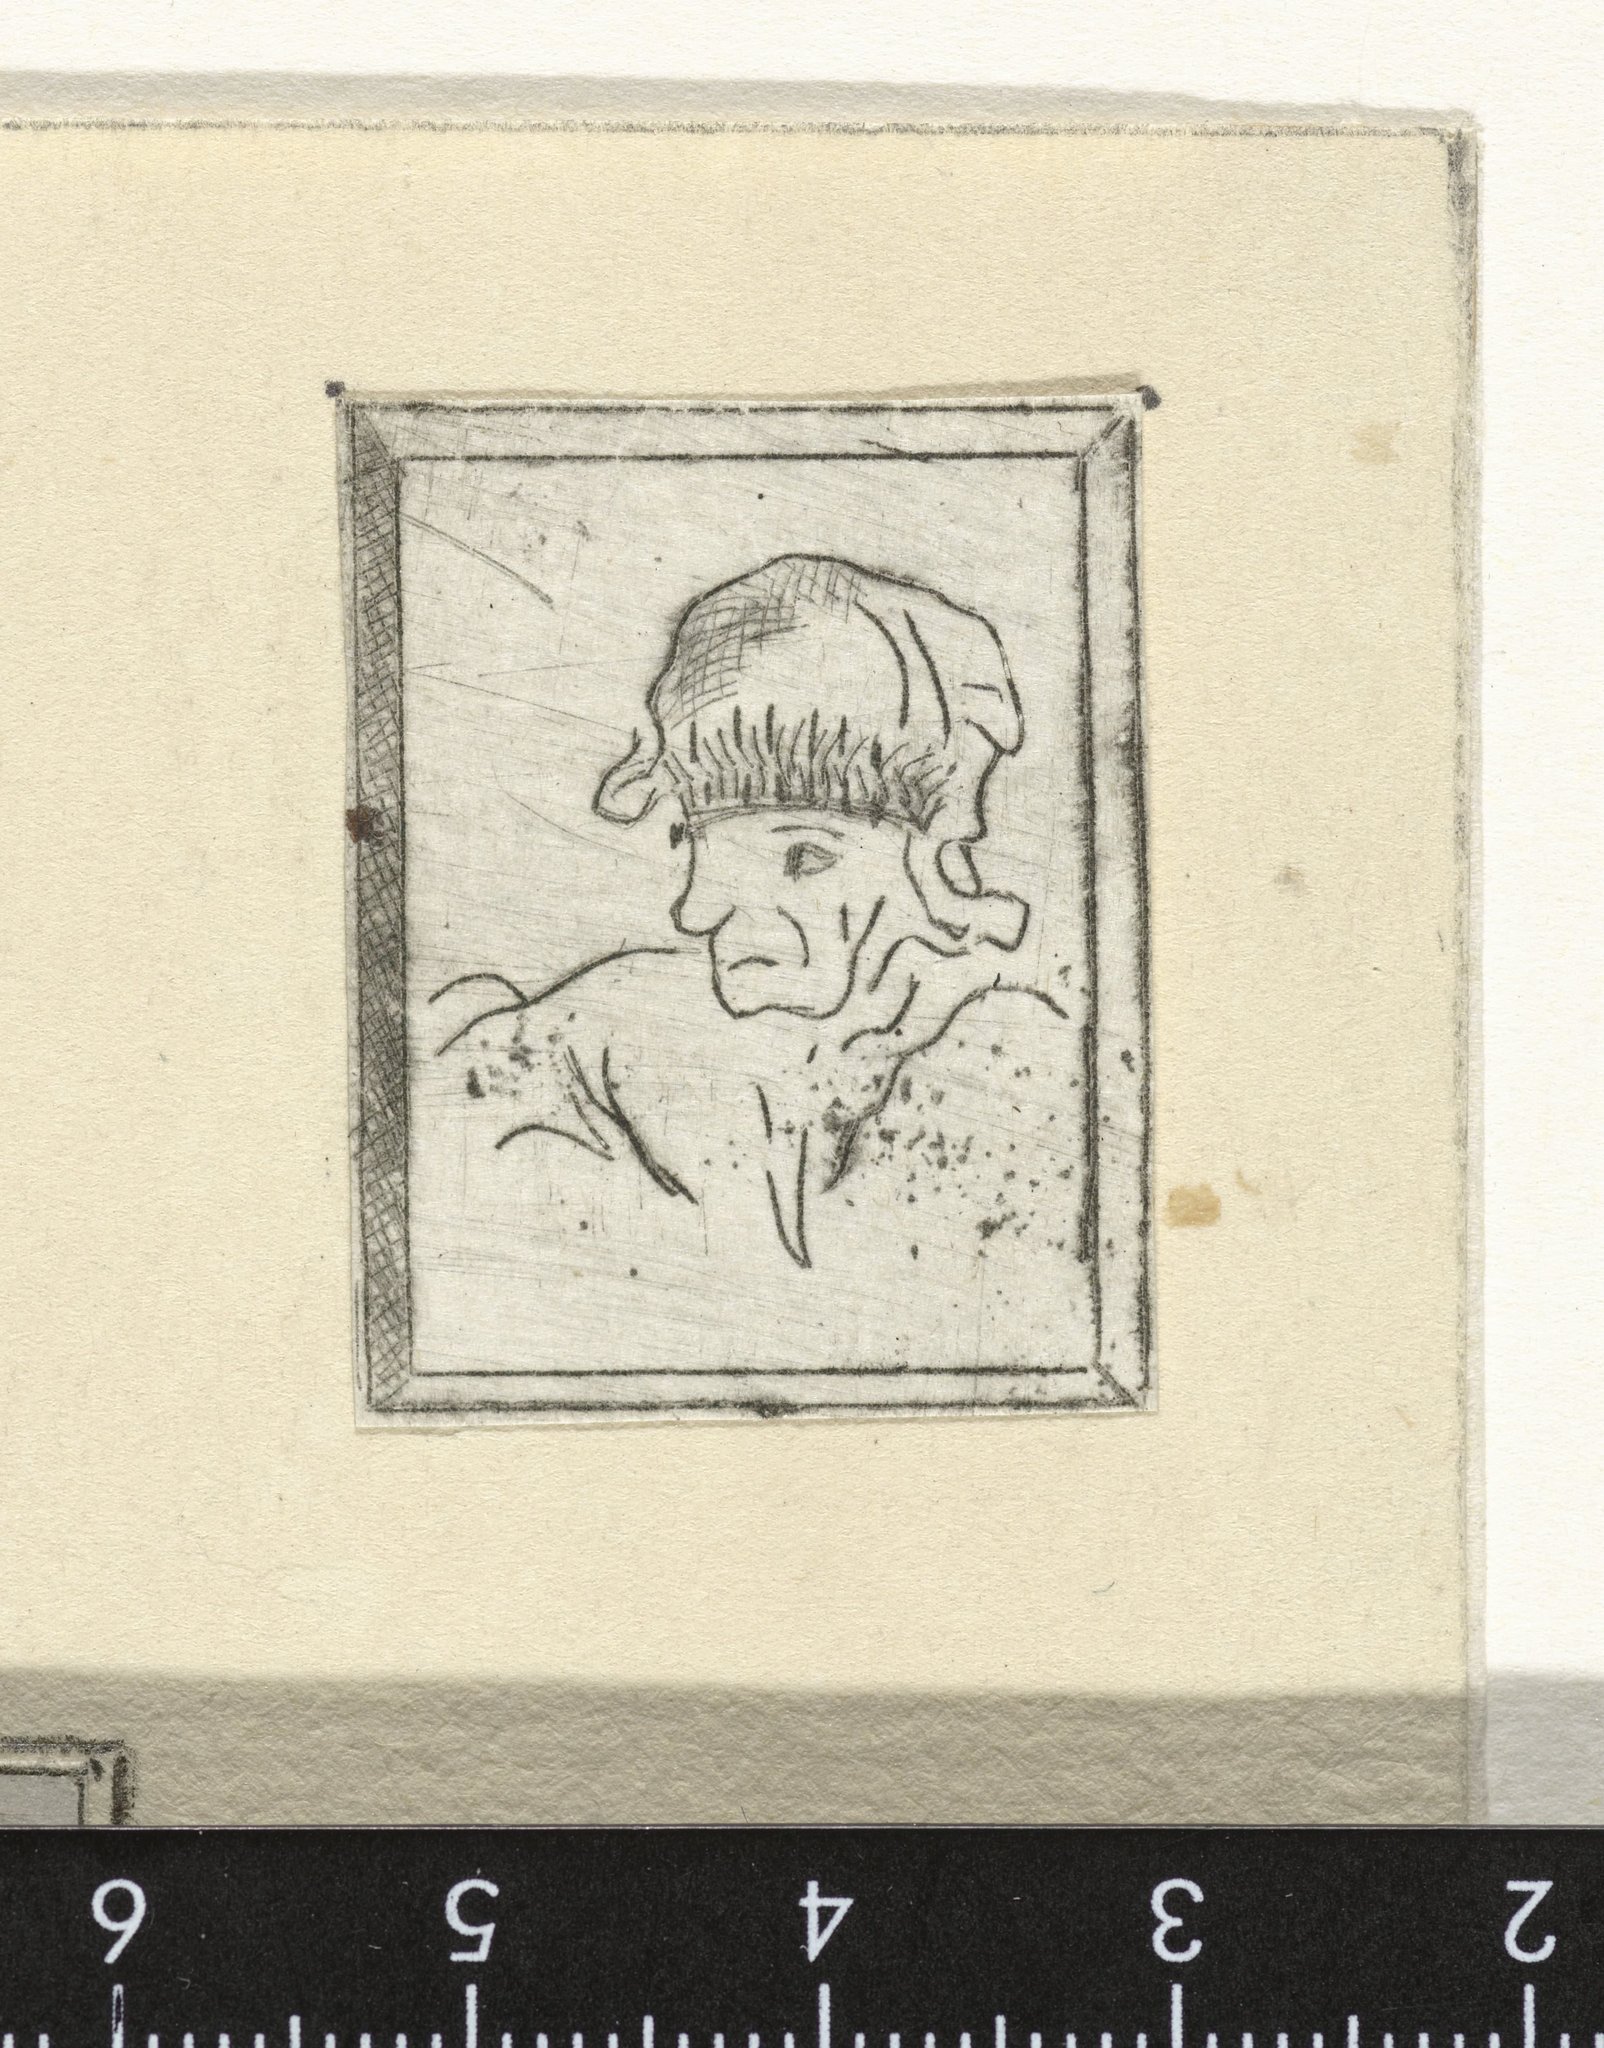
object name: print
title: Mannenkop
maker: jacob hoolaart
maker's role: print maker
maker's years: 1713-1789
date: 1728-1789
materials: paper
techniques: etching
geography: dordrecht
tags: head-gear: hat (+ men's clothes)